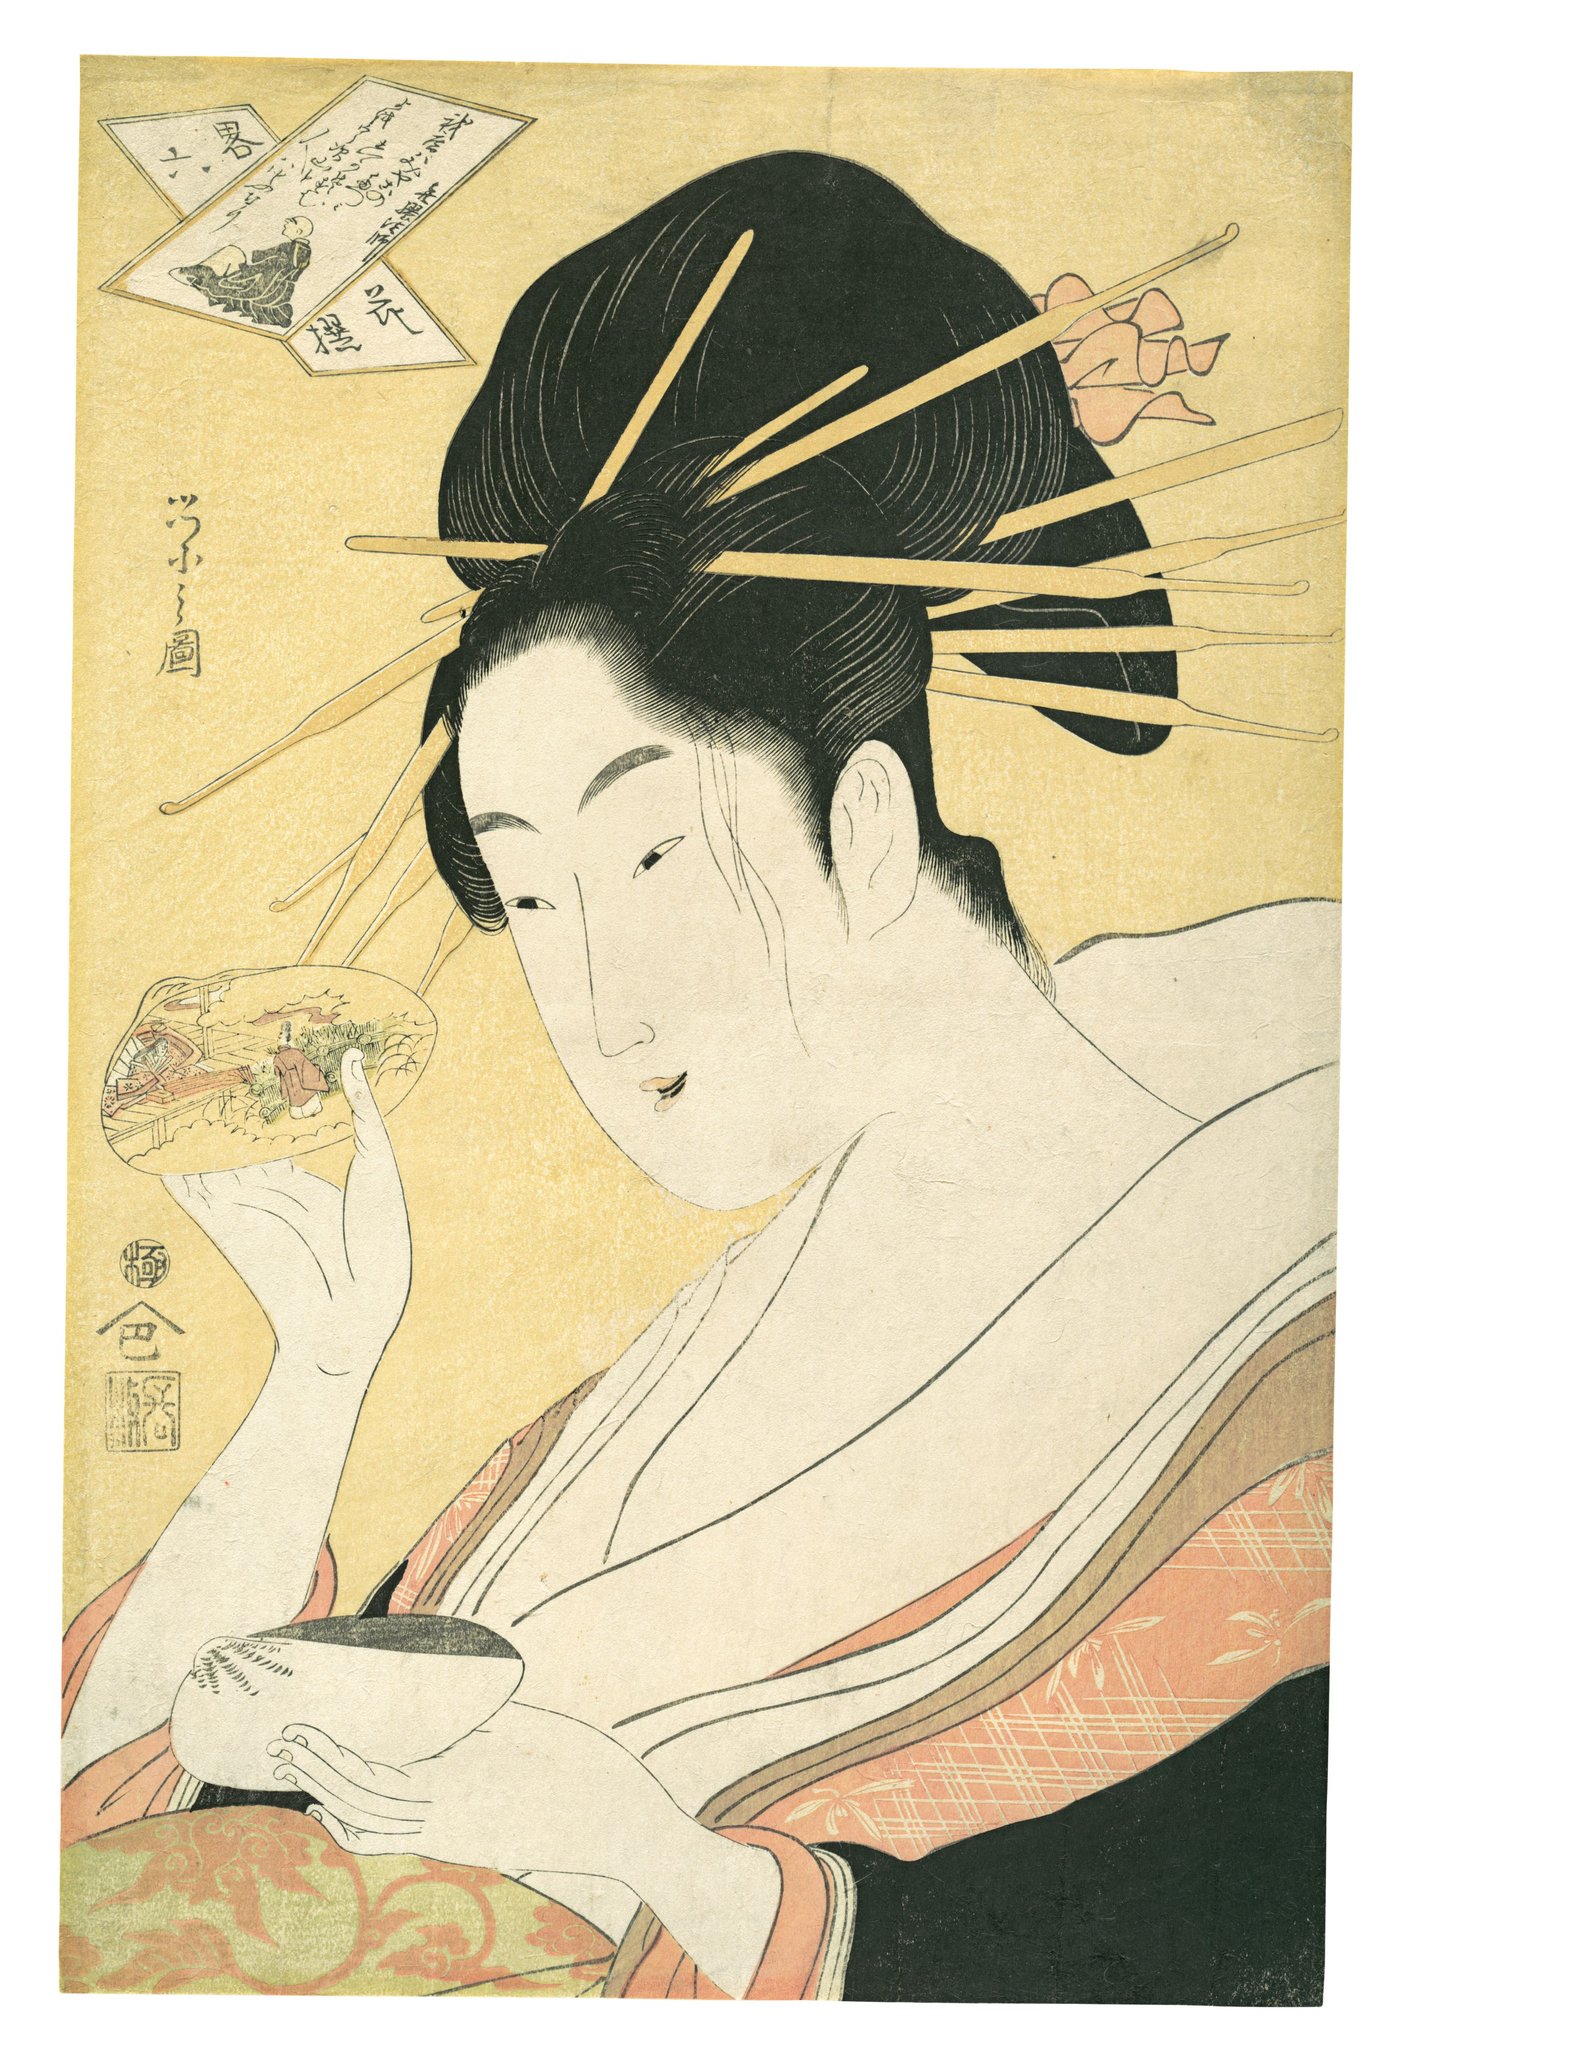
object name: print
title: Matching Shells (Kai-awase), “Kisen Hōshi,” from the series Modern Parodies of the Six Poetic Immortals (Yatsushi rokkasen: Kisen Hōshi)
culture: japanese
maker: chōbunsai eishi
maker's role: artist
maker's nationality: japanese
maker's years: 1756-1829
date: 1796-1798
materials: ink, paper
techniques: polychrome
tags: women,shells